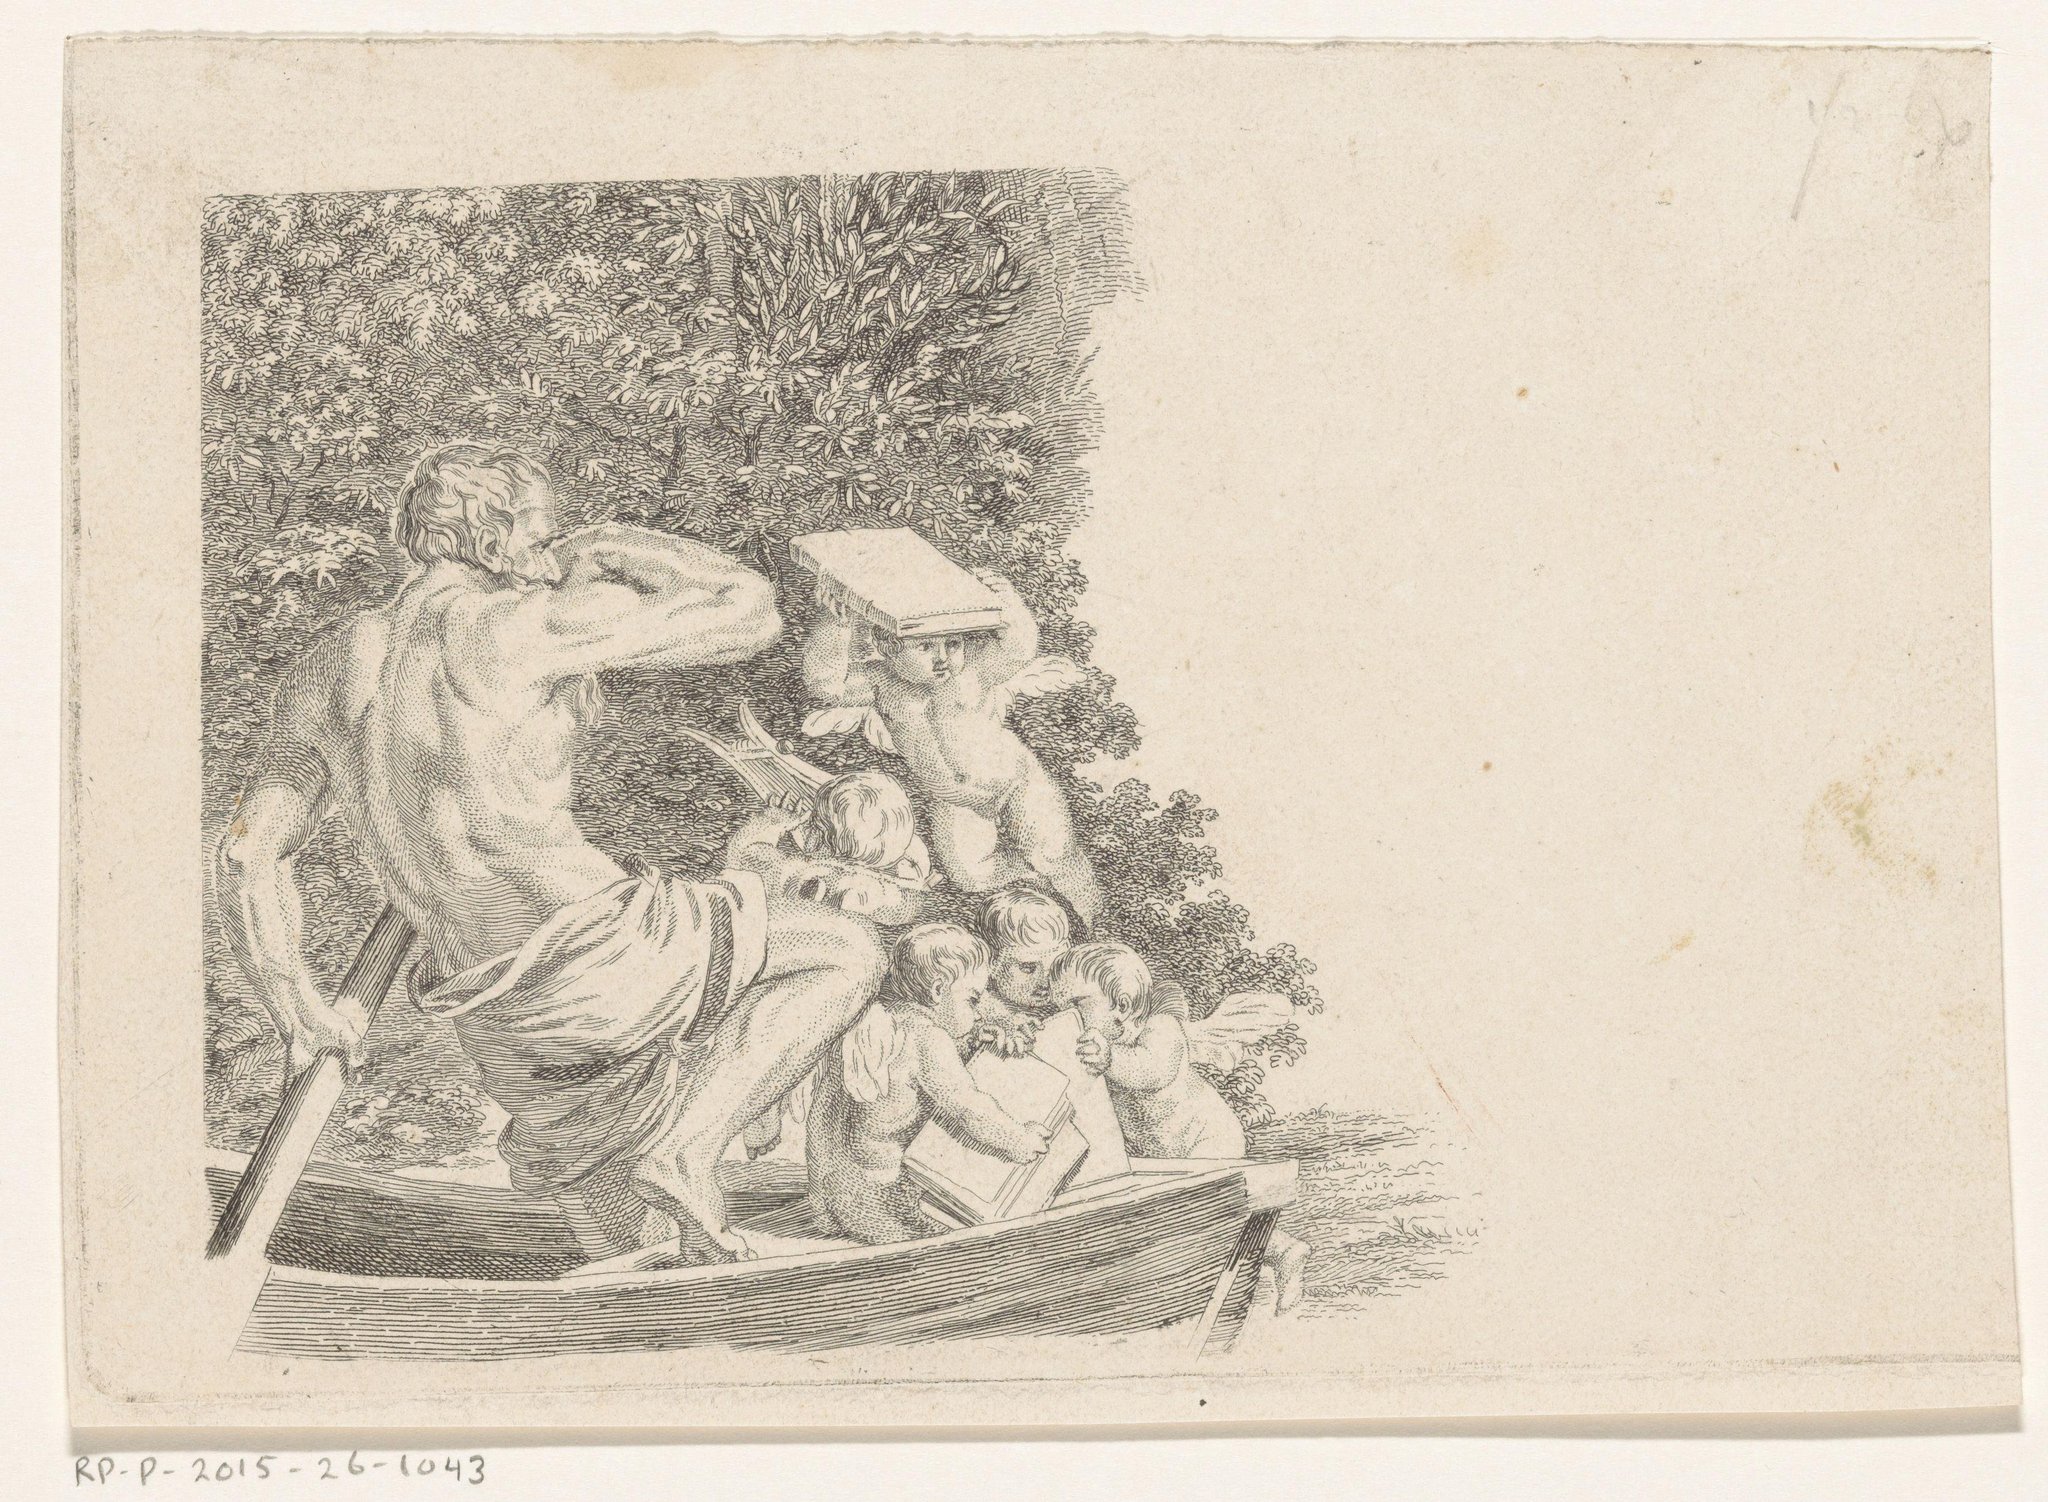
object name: print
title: Vijf putti met boeken en een harp in een boot geduwd door een man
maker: Anonymous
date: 1800-1899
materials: paper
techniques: etching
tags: book, cupids: 'amores', 'amoretti', 'putti', boat propelled by man or animal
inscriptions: collector's mark: Lugt 4779, collector's mark: Lugt 2228